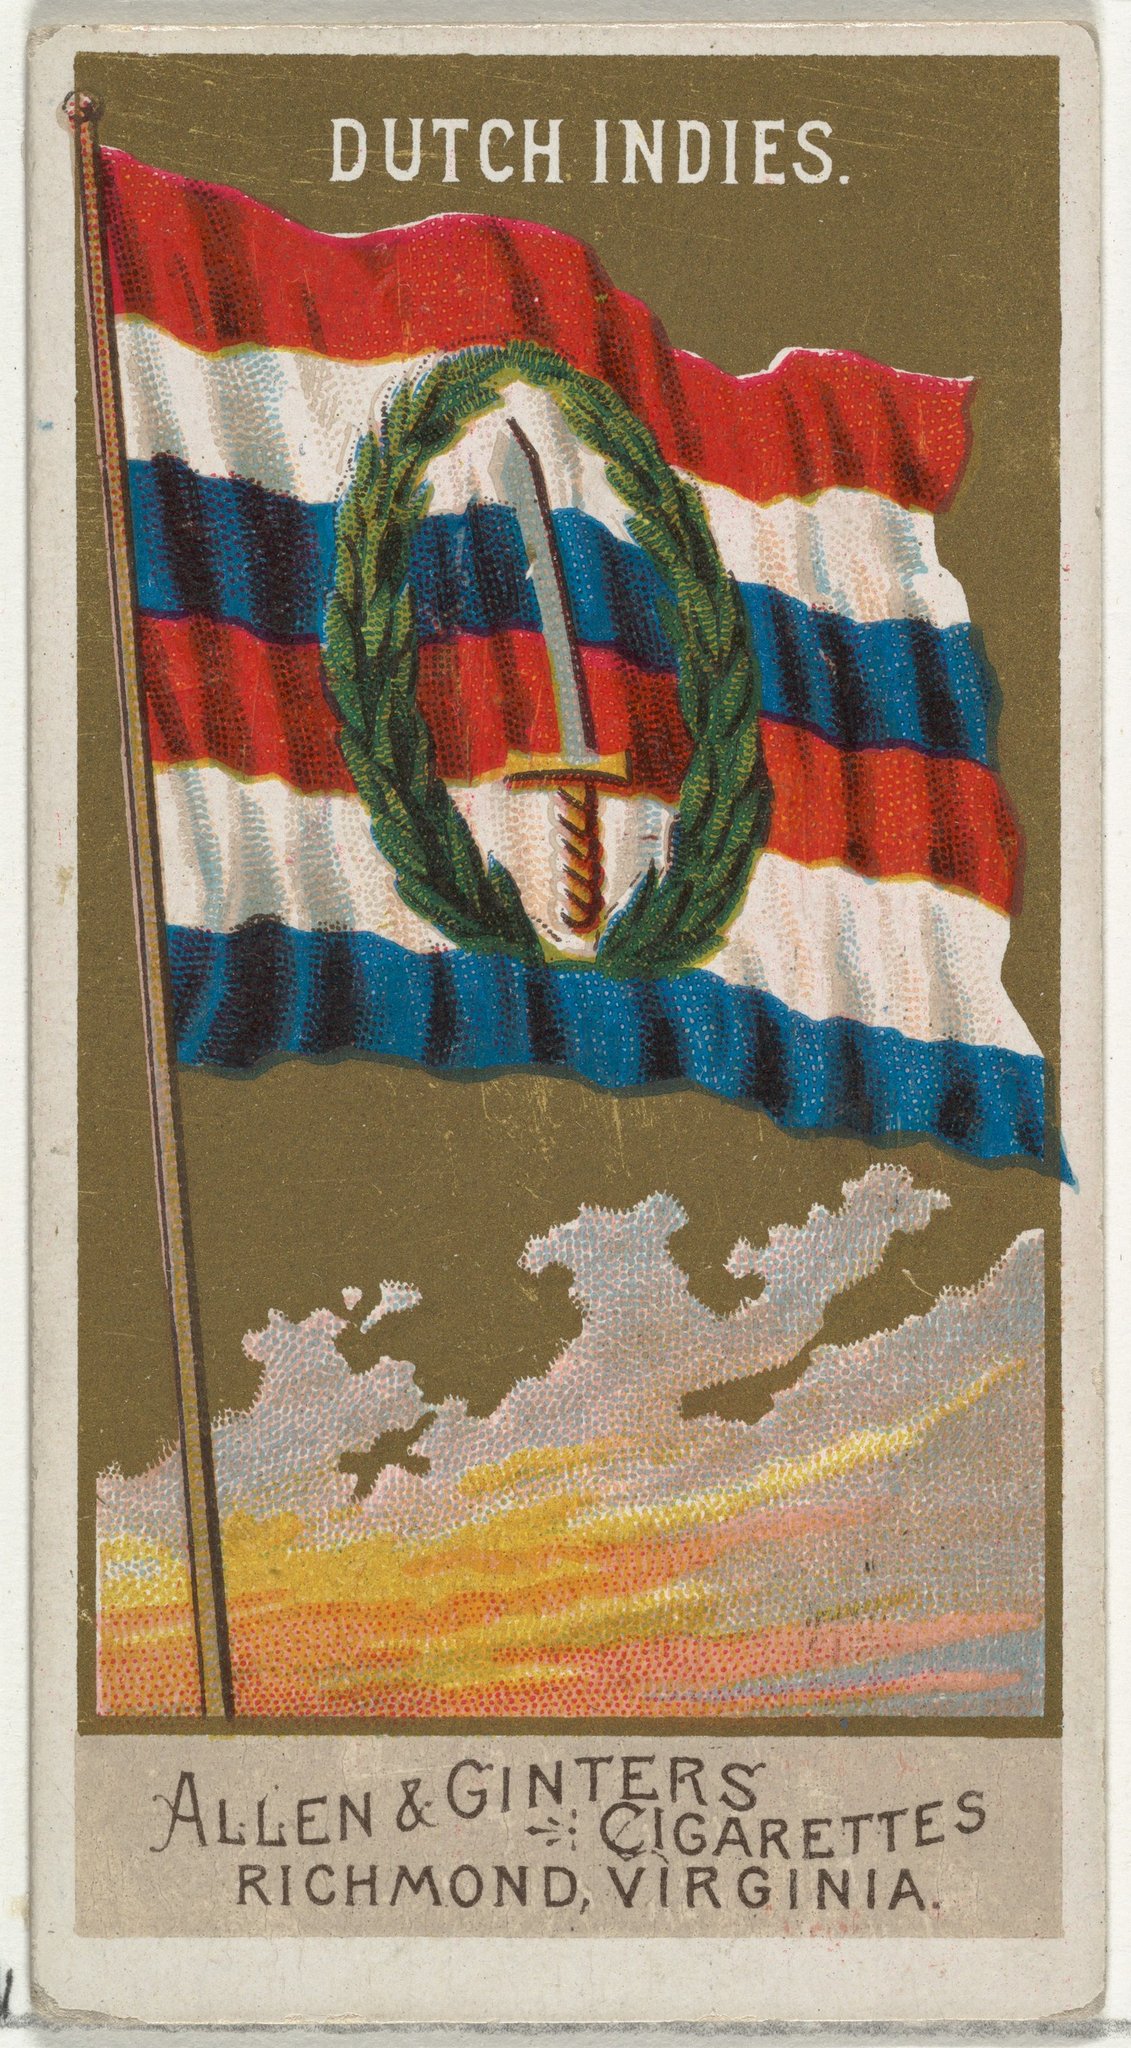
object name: print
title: Dutch Indies, from Flags of All Nations, Series 2 (N10) for Allen & Ginter Cigarettes Brands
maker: allen & ginter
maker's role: publisher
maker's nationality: american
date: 1890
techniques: color lithograph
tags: flags